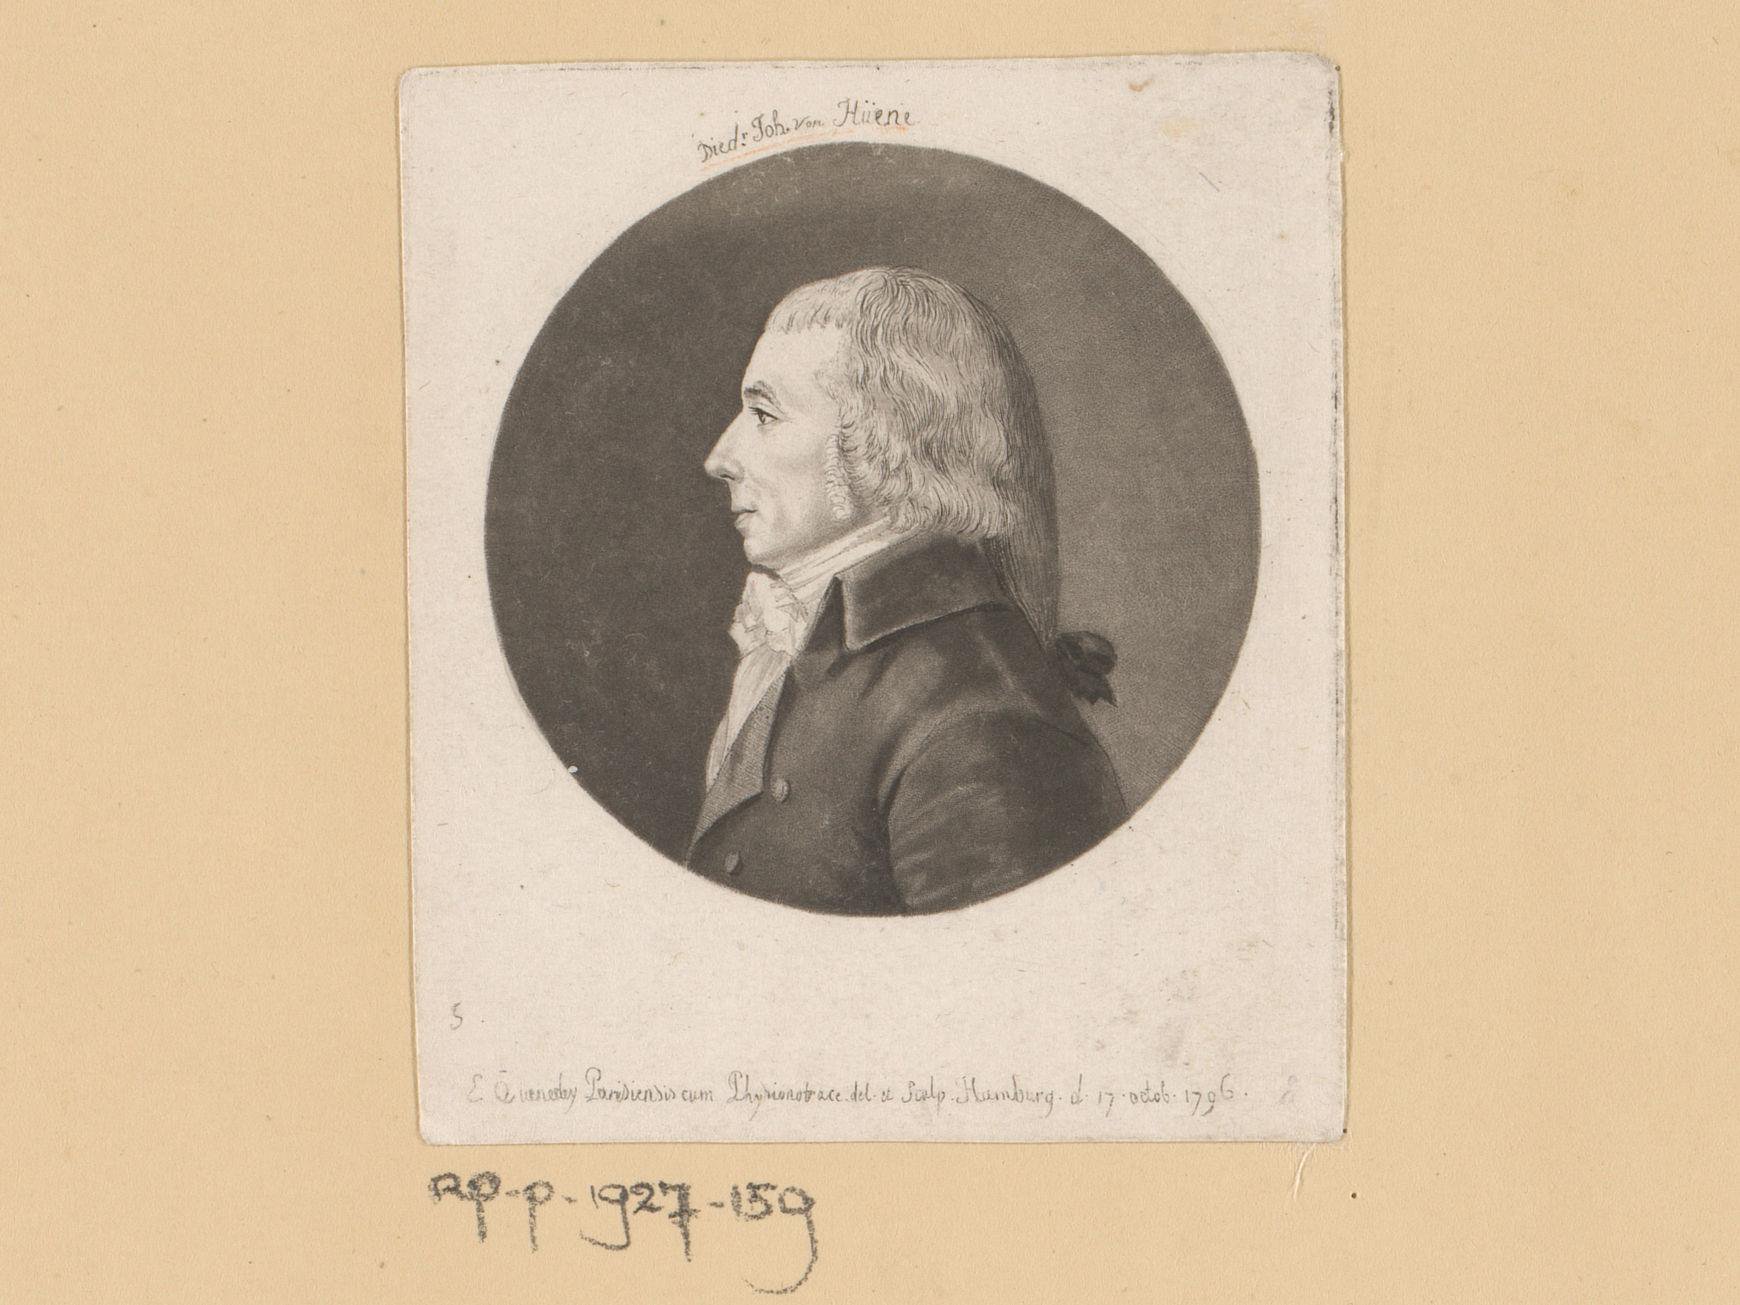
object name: physionotrace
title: Portret van een onbekende man, Died. Joh. von Hüene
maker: edme quenedey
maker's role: print maker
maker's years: 1756-1830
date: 1796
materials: paper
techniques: aquatint, etching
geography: hamburg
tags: silhouette-apparatus, 'physionotrace', anonymous historical person portrayed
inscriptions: collector's mark: Lugt 2166